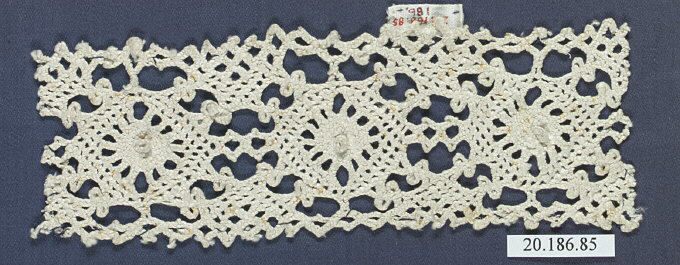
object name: insertion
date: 1501-1600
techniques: lace